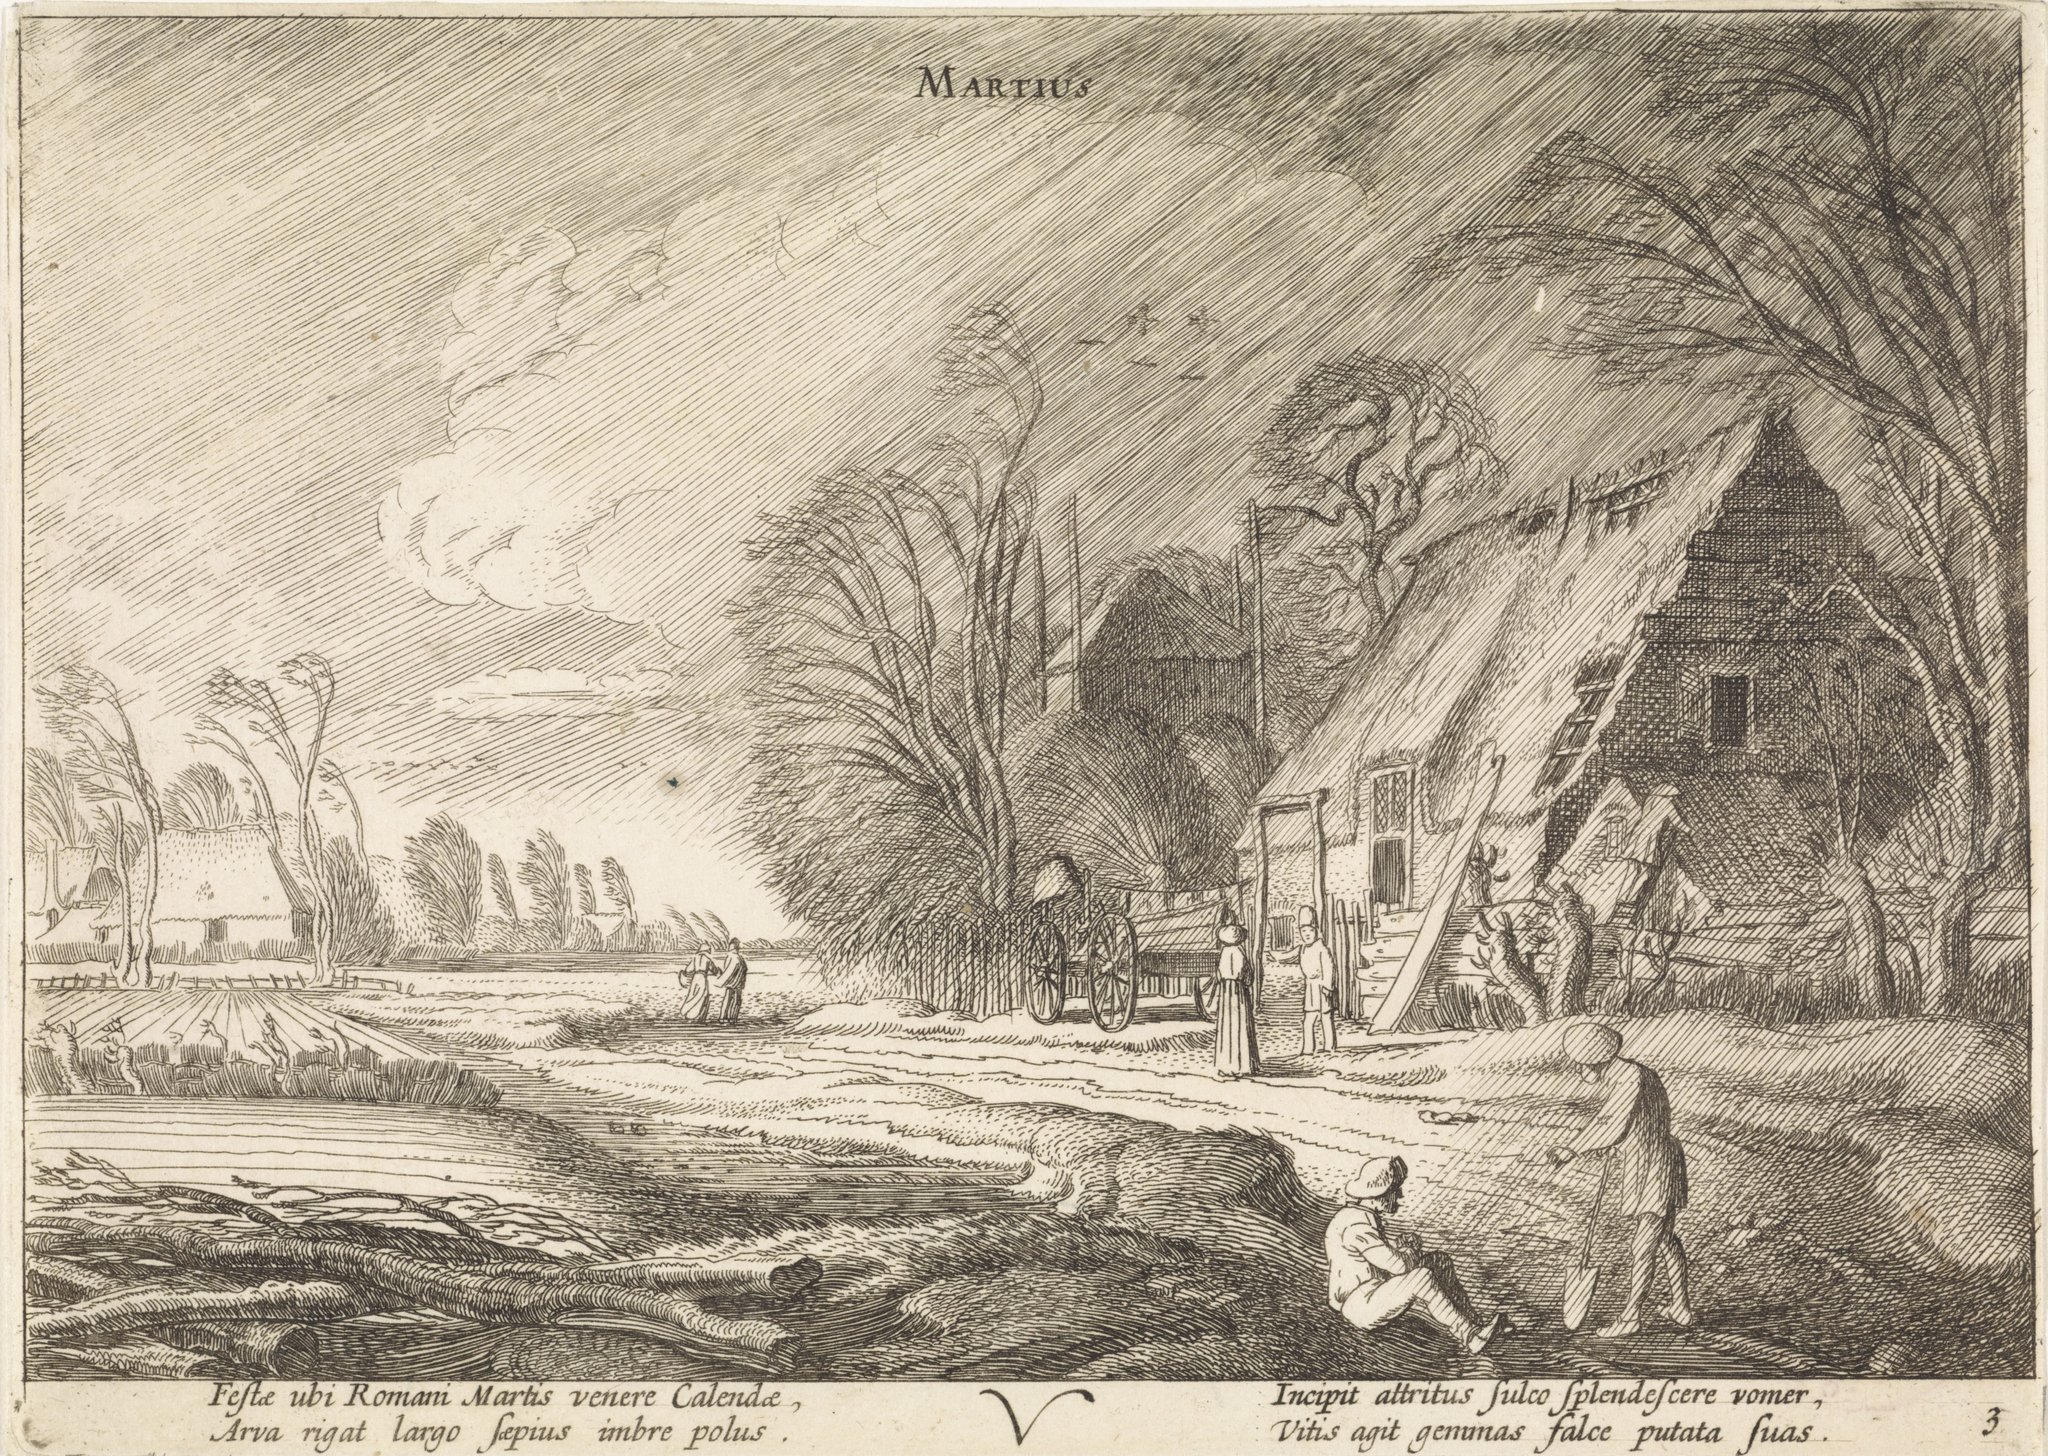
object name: print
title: De twaalf maanden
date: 1608-1618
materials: paper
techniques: engraving, etching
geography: northern netherlands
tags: landscape symbolizing march, rain, aries (zodical sign of march), (farm) wagon, freight wagon, cart, farm (building)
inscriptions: collector's mark: Lugt 240, collector's mark: Lugt 698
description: Een landschap met figuren op een landweg voor een boerderij met een hooiberg bij zware regenval, voorstellende de maand maart. Onderaan het astrologische symbool van het sterrenbeeld ram. Prent uit een serie van twaalf.